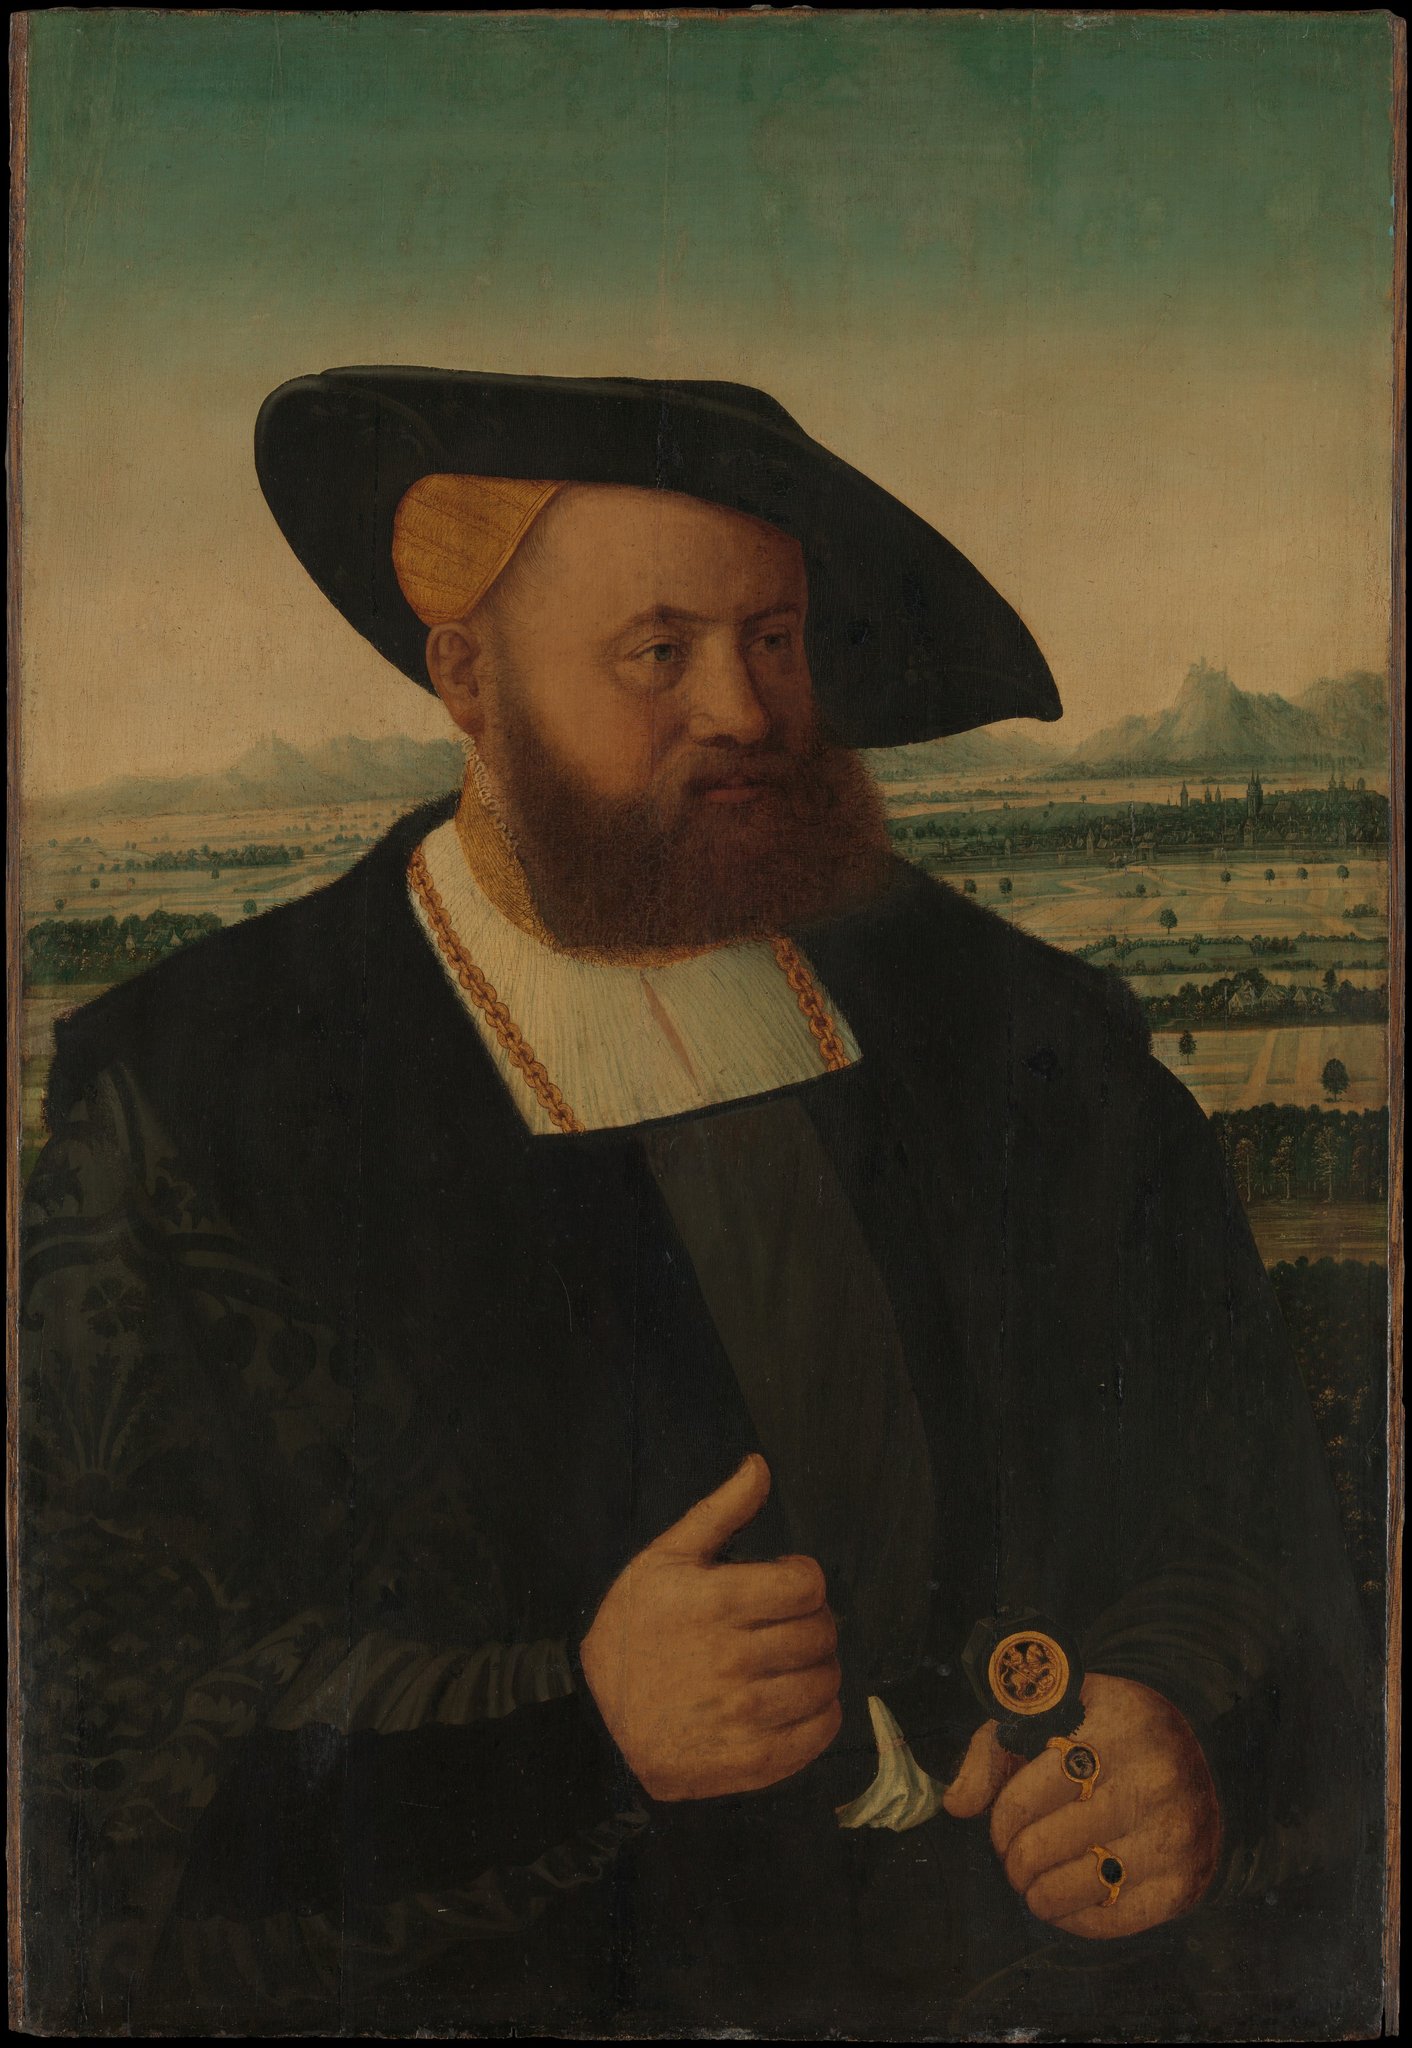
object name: painting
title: Portrait of a Man with a Moor's Head on His Signet Ring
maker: conrad faber von creuznach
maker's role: artist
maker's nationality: german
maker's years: 1524-1553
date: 1524-1553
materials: gold, wood, metal, oil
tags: rings,men,portraits